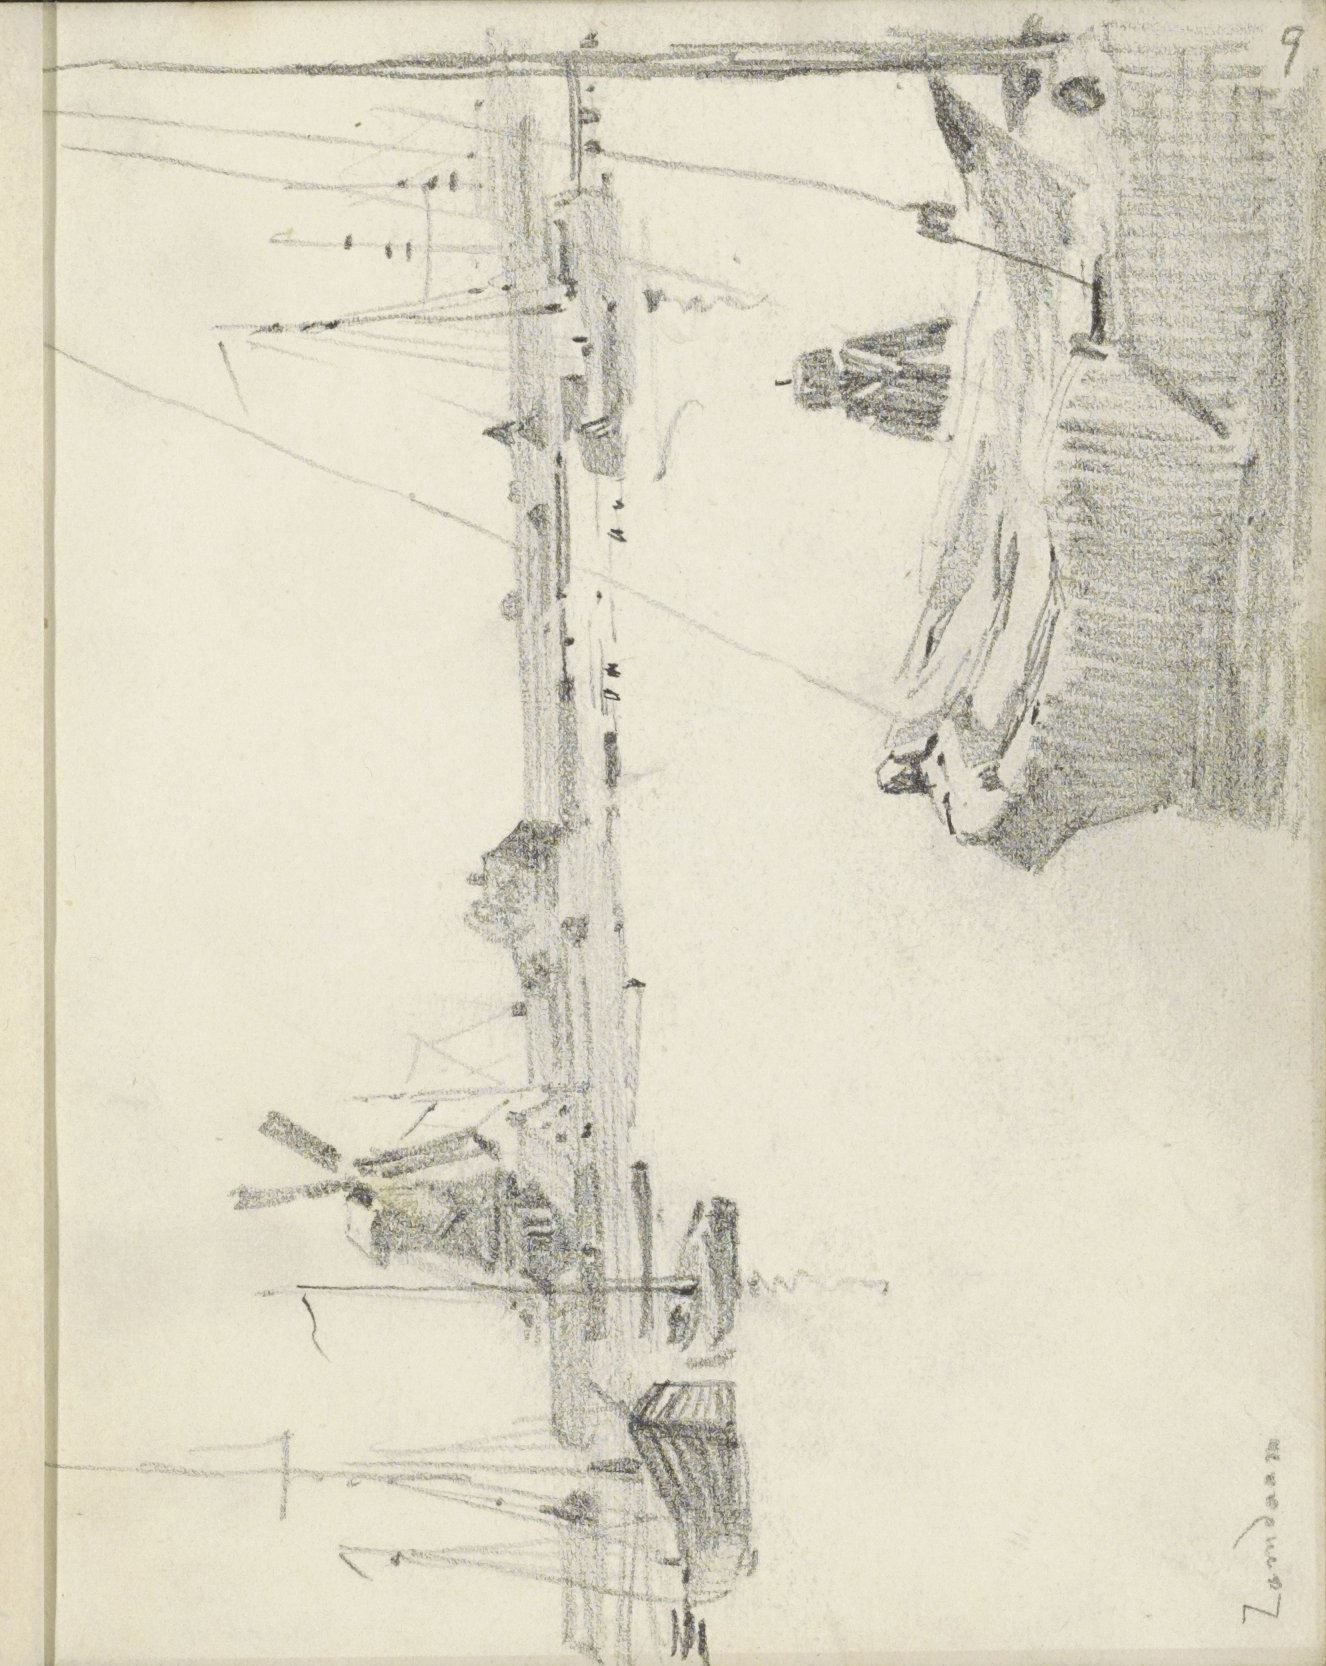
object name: sketchbook leaf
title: Molen De Roode Leeuw bij Zaandam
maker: alfred william rich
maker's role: draughtsman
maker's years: 1856-1921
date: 1892-1893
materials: paper, pencil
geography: zaandam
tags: sailing-ship, sailing-boat, landscapes with waters, waterscapes, seascapes (in the temperate zone), windmill in landscape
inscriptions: annotation: ‘Zamdaam’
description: Langs de kade liggen zeilboten aangemeerd. Blad 9 recto uit een schetsboek met 86 bladen.